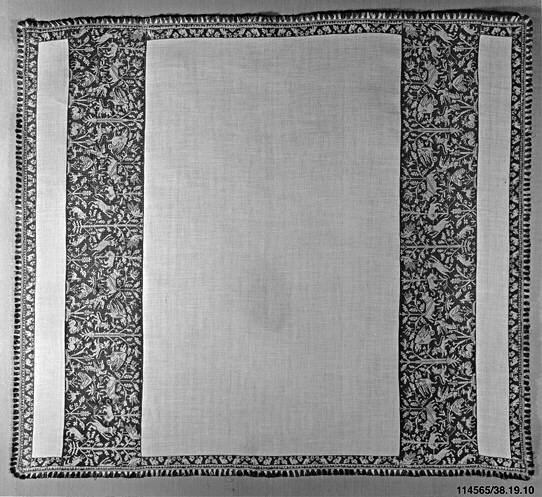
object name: cover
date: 1501-1700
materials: linen, silk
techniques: embroidery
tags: animals